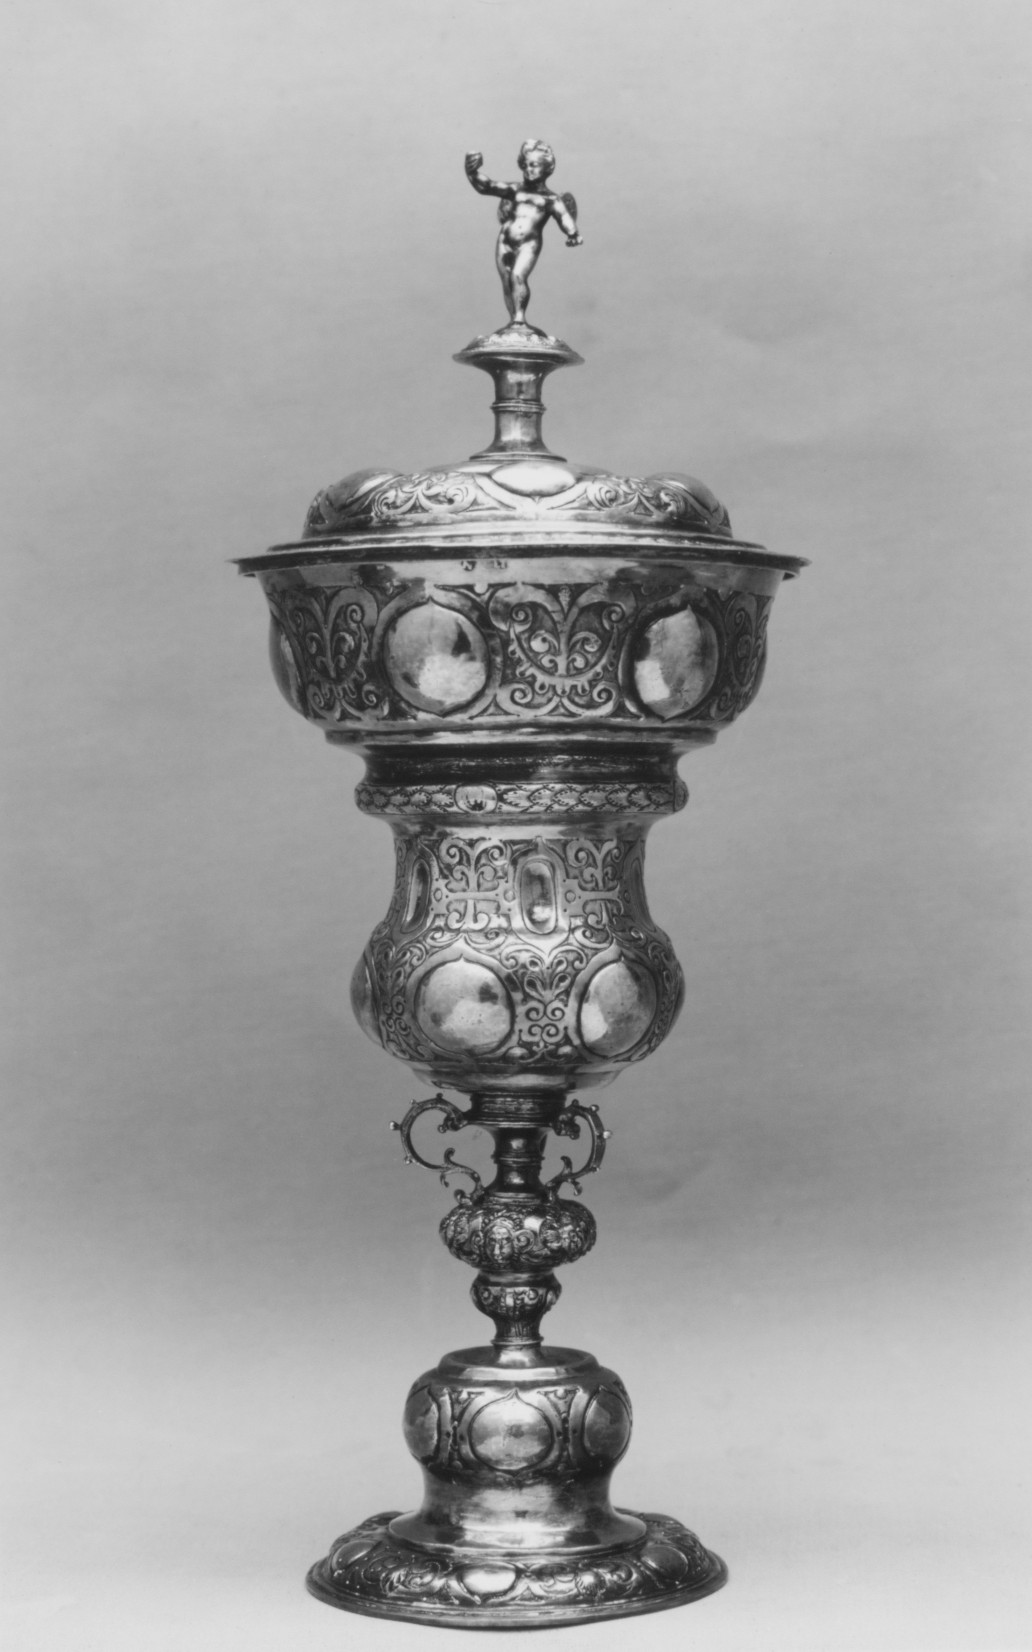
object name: standing cup with cover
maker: l. t., nuremburg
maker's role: maker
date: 1601-1650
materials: silver gilt